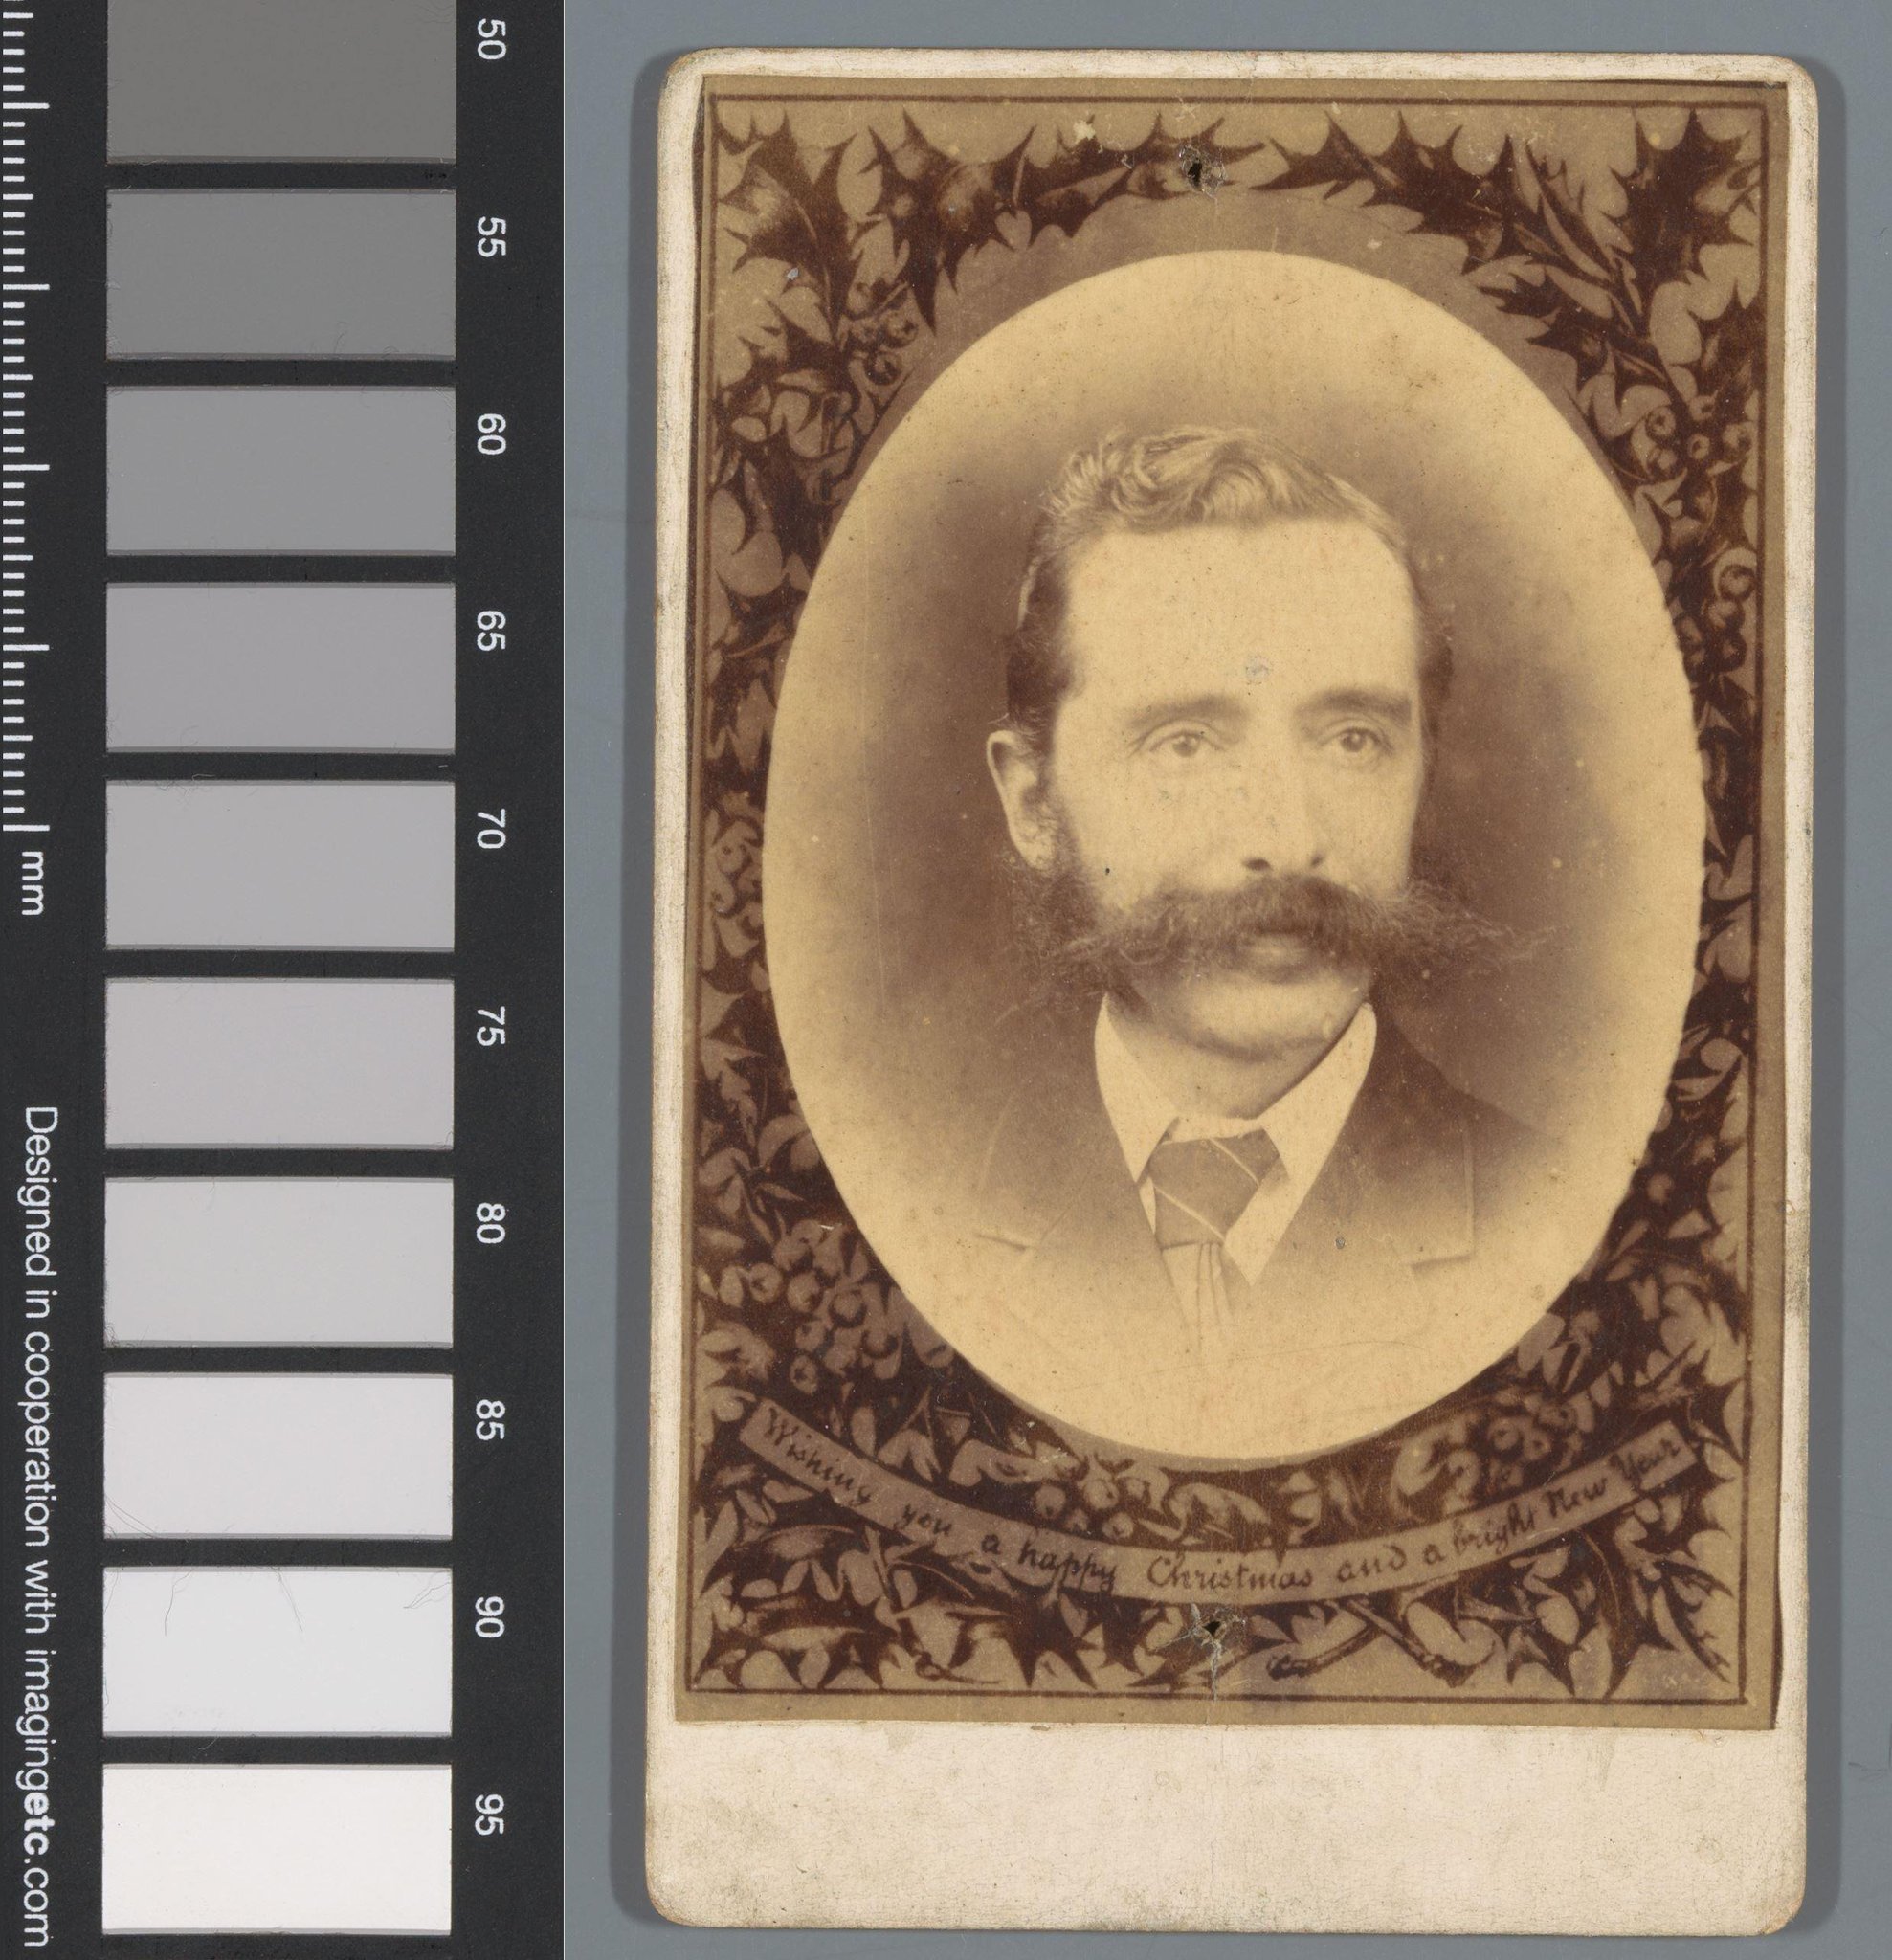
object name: carte de visite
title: Kerstkaart met een portret van een onbekende man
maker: Anonymous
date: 1880-1900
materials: cardboard, paper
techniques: albumen print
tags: moustache, adult man, historical persons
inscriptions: inscription: ‘Wishing you a happy Christmas and a bright New Year’